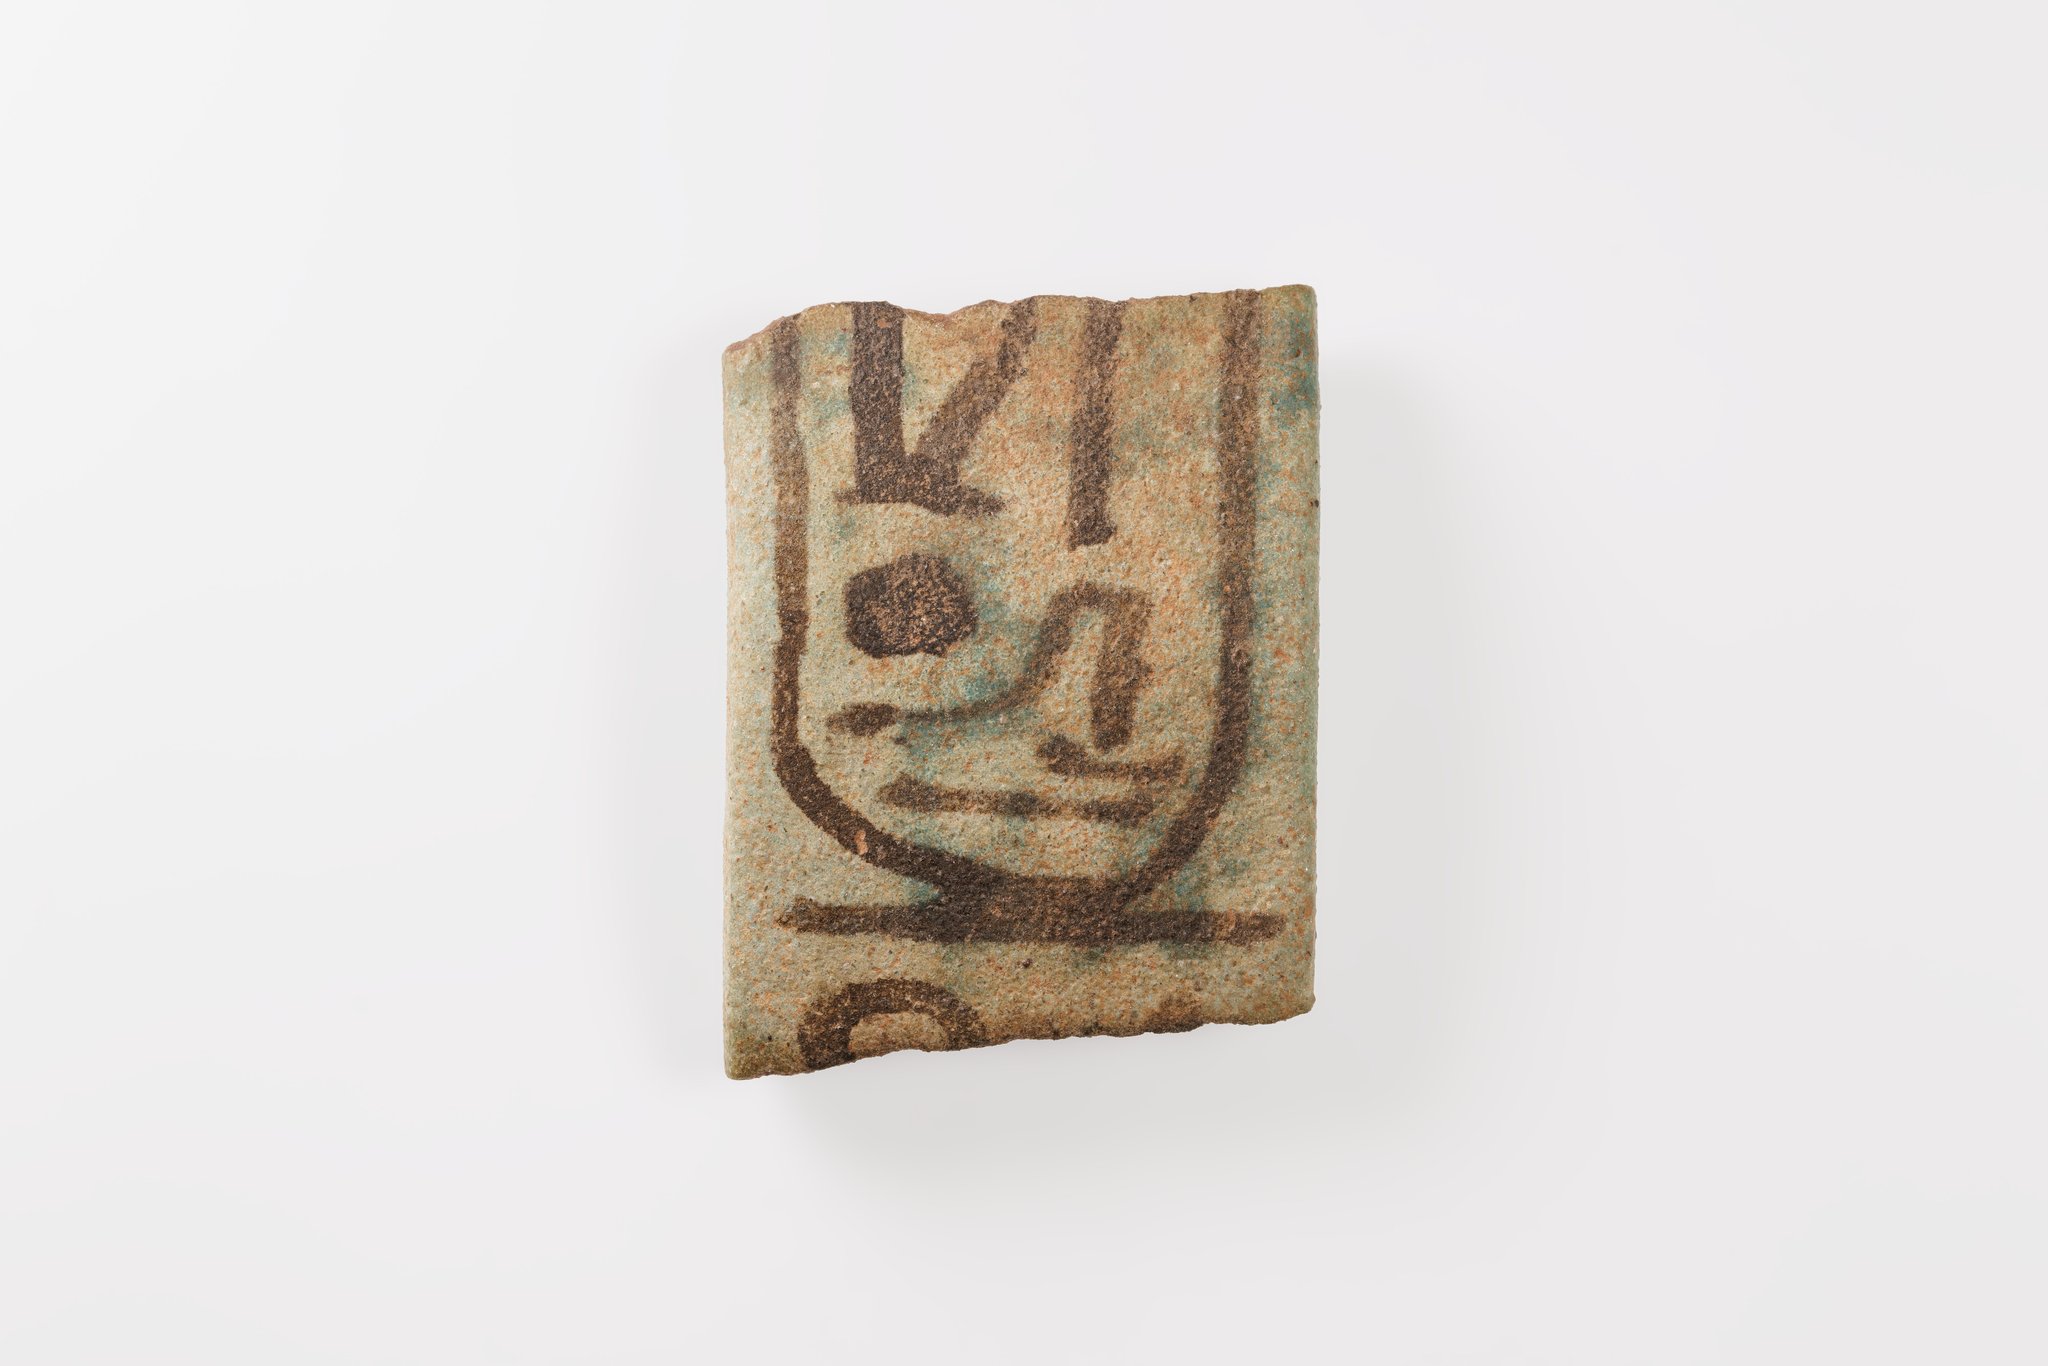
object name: votive bracelet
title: Fragment of a votive bracelet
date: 1295-1070 BCE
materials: faience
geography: egypt